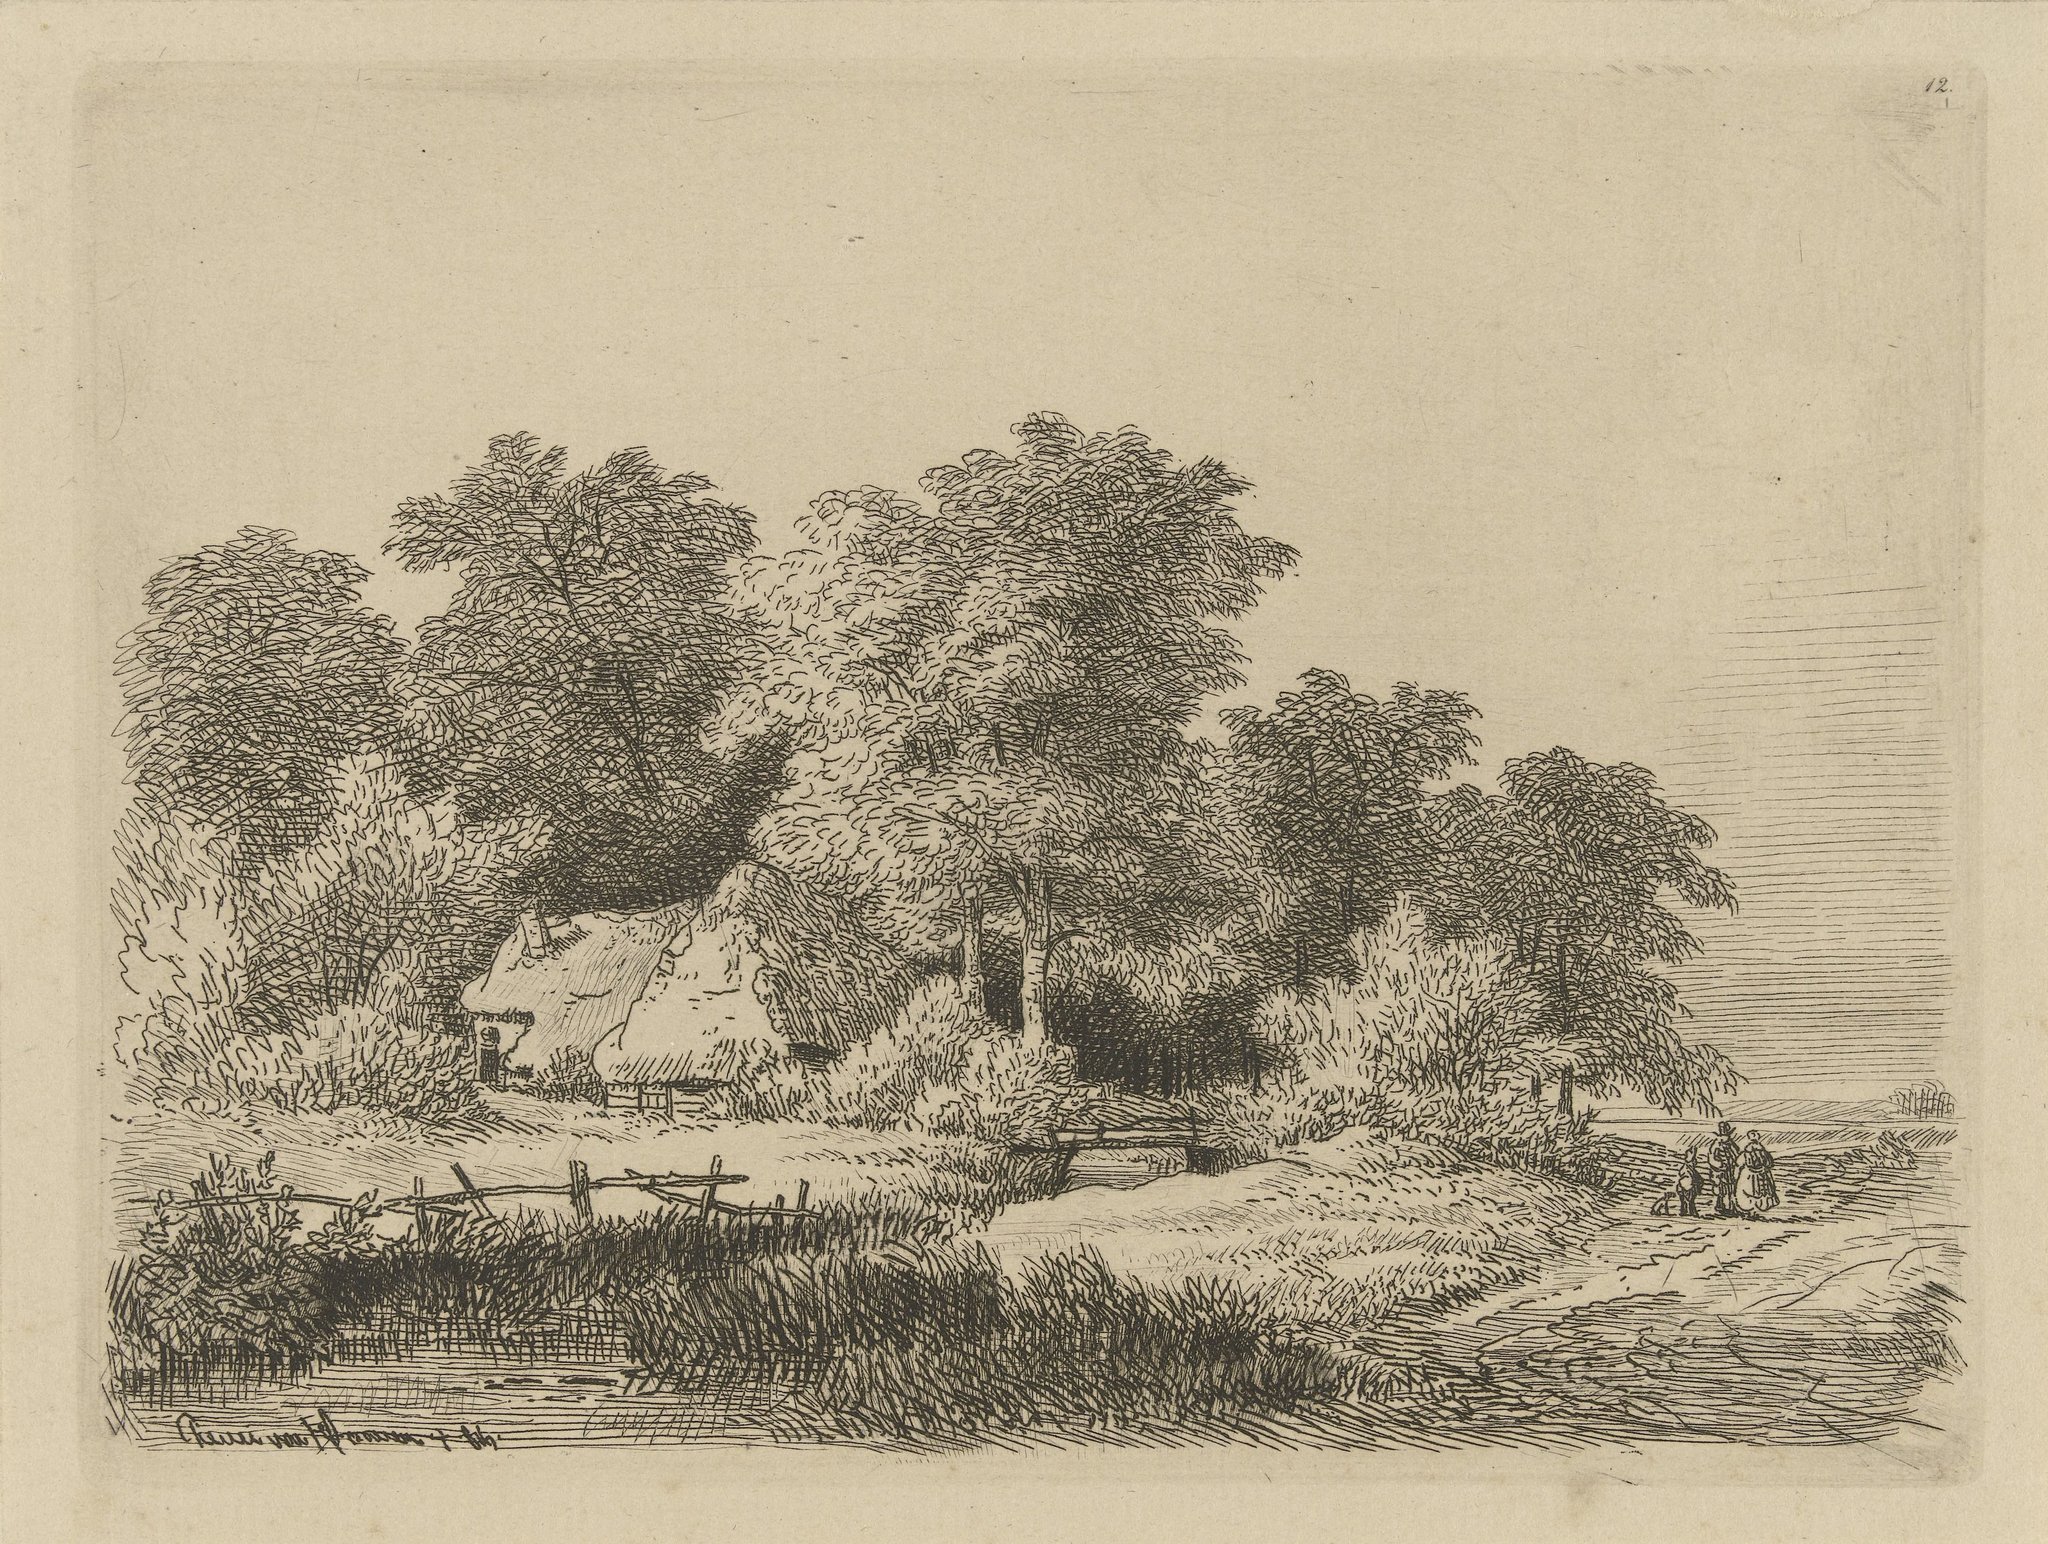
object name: print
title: Gezelschap op een landweg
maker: remigius adrianus haanen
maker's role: draughtsman, painter, print maker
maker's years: 1812-1894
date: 1849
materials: paper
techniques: etching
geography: austria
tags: landscapes (+ landscape with figures, staffage)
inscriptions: collector's mark: Lugt 2228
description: Drie figuren en een hond op een landweg bij een boerderij tussen bomen.